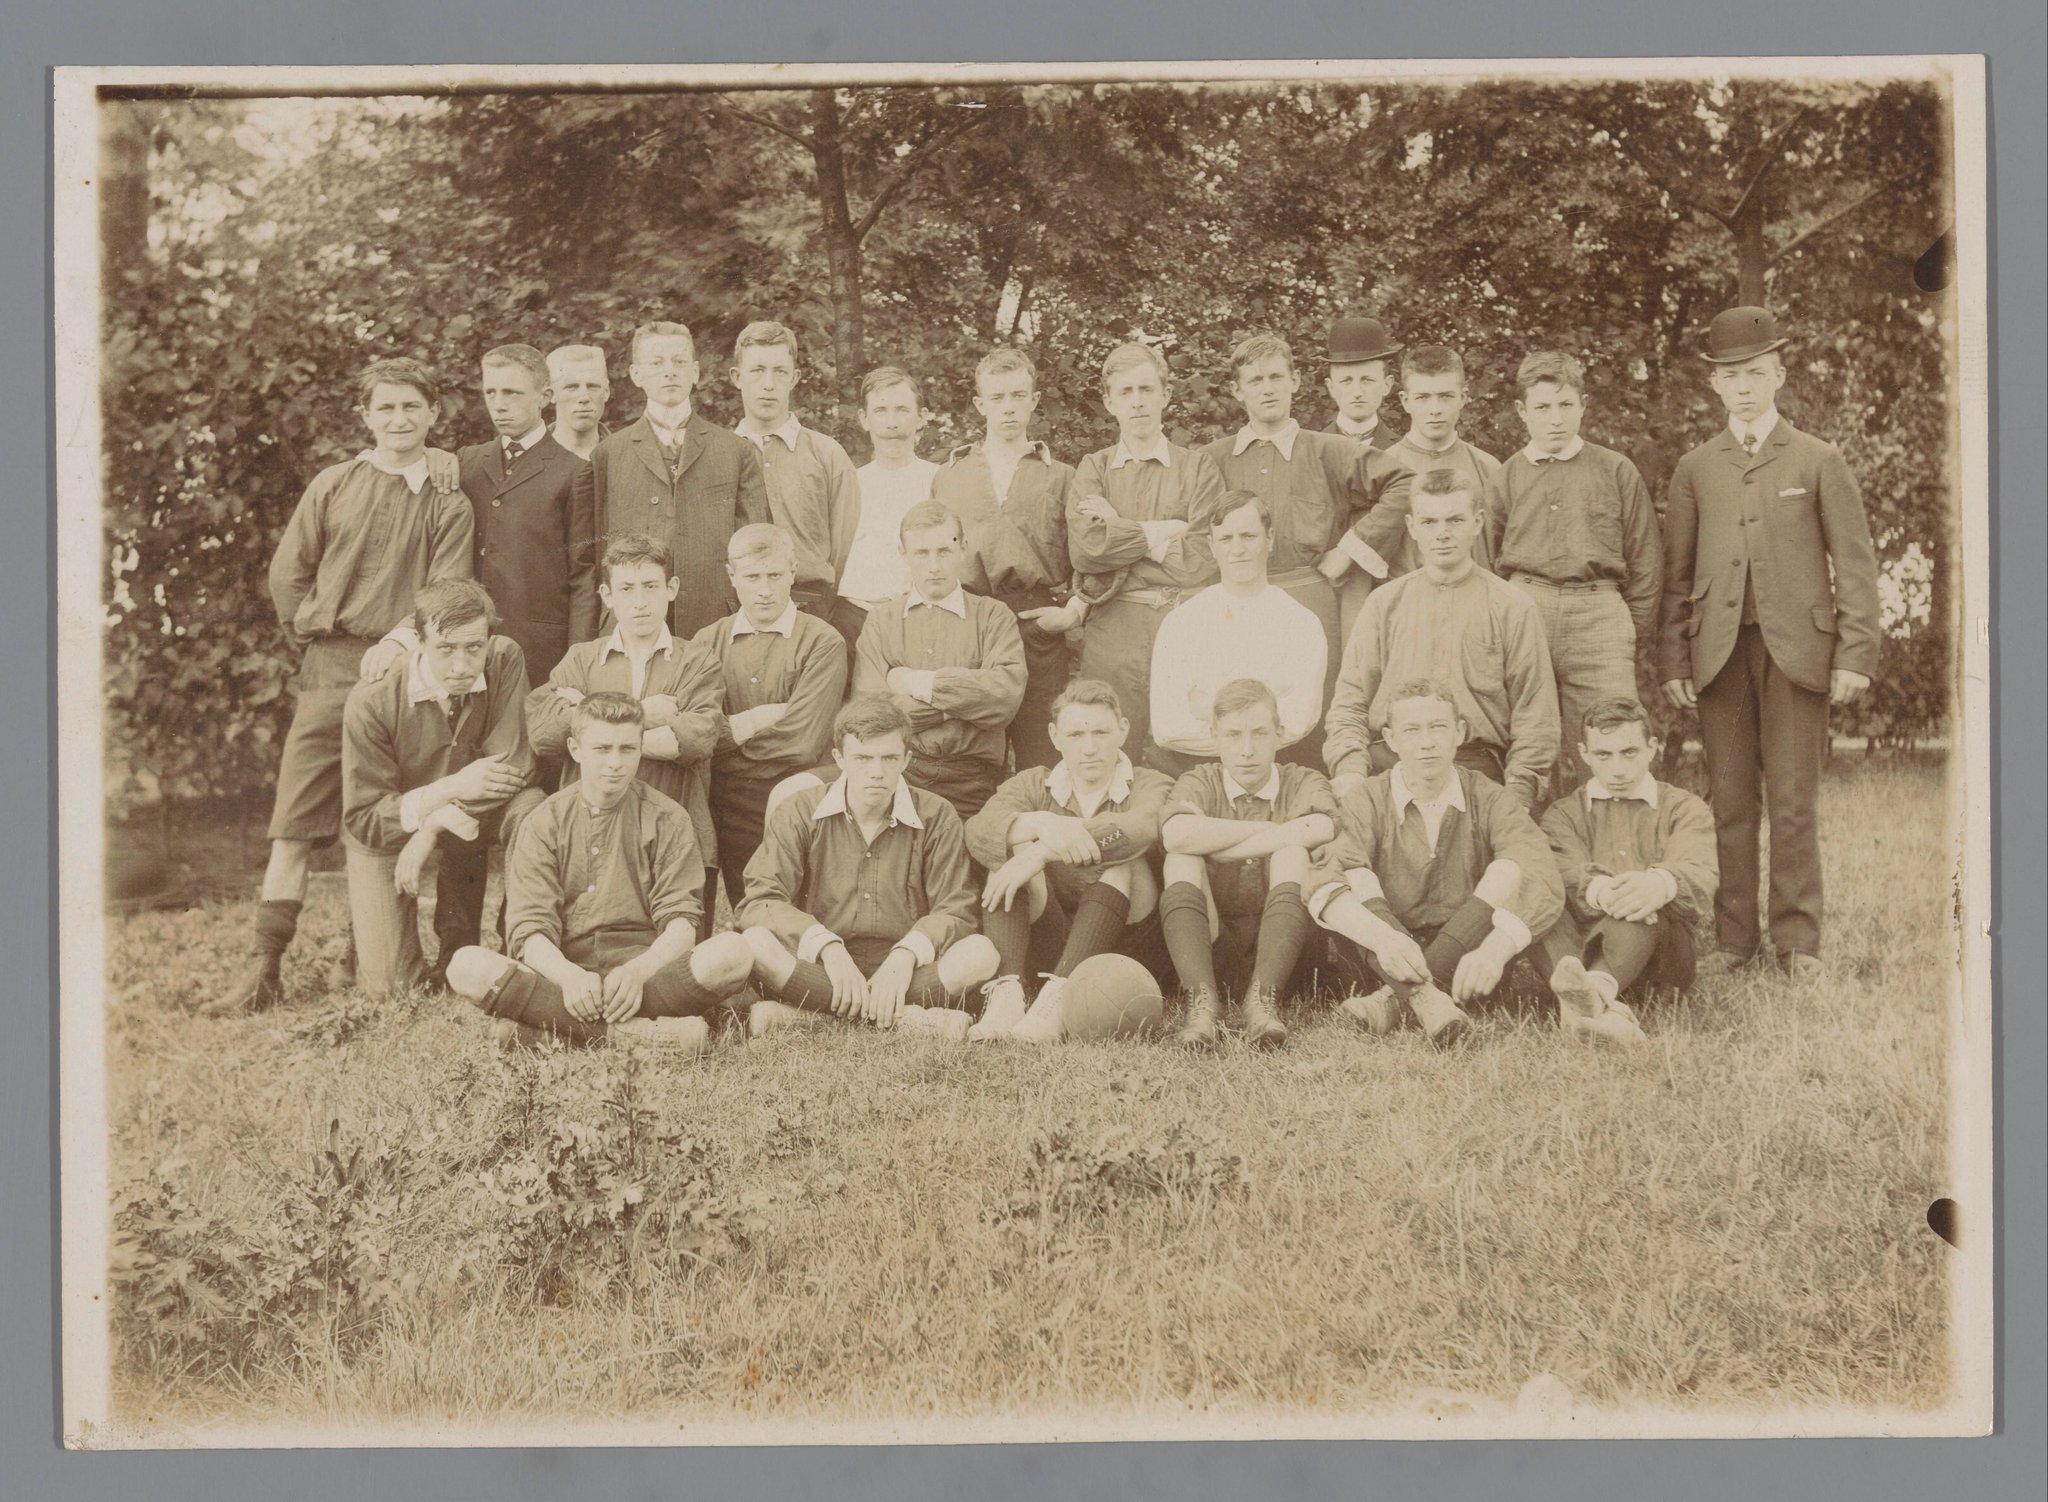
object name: photograph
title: Groepsportret van (vermoedelijk) een voetbalteam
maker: Anonymous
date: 1895-1915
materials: photographic support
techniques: gelatin silver print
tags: soccer, football (early names: soule, choule, cholle), anonymous historical persons portrayed in a group, in a group-portrait